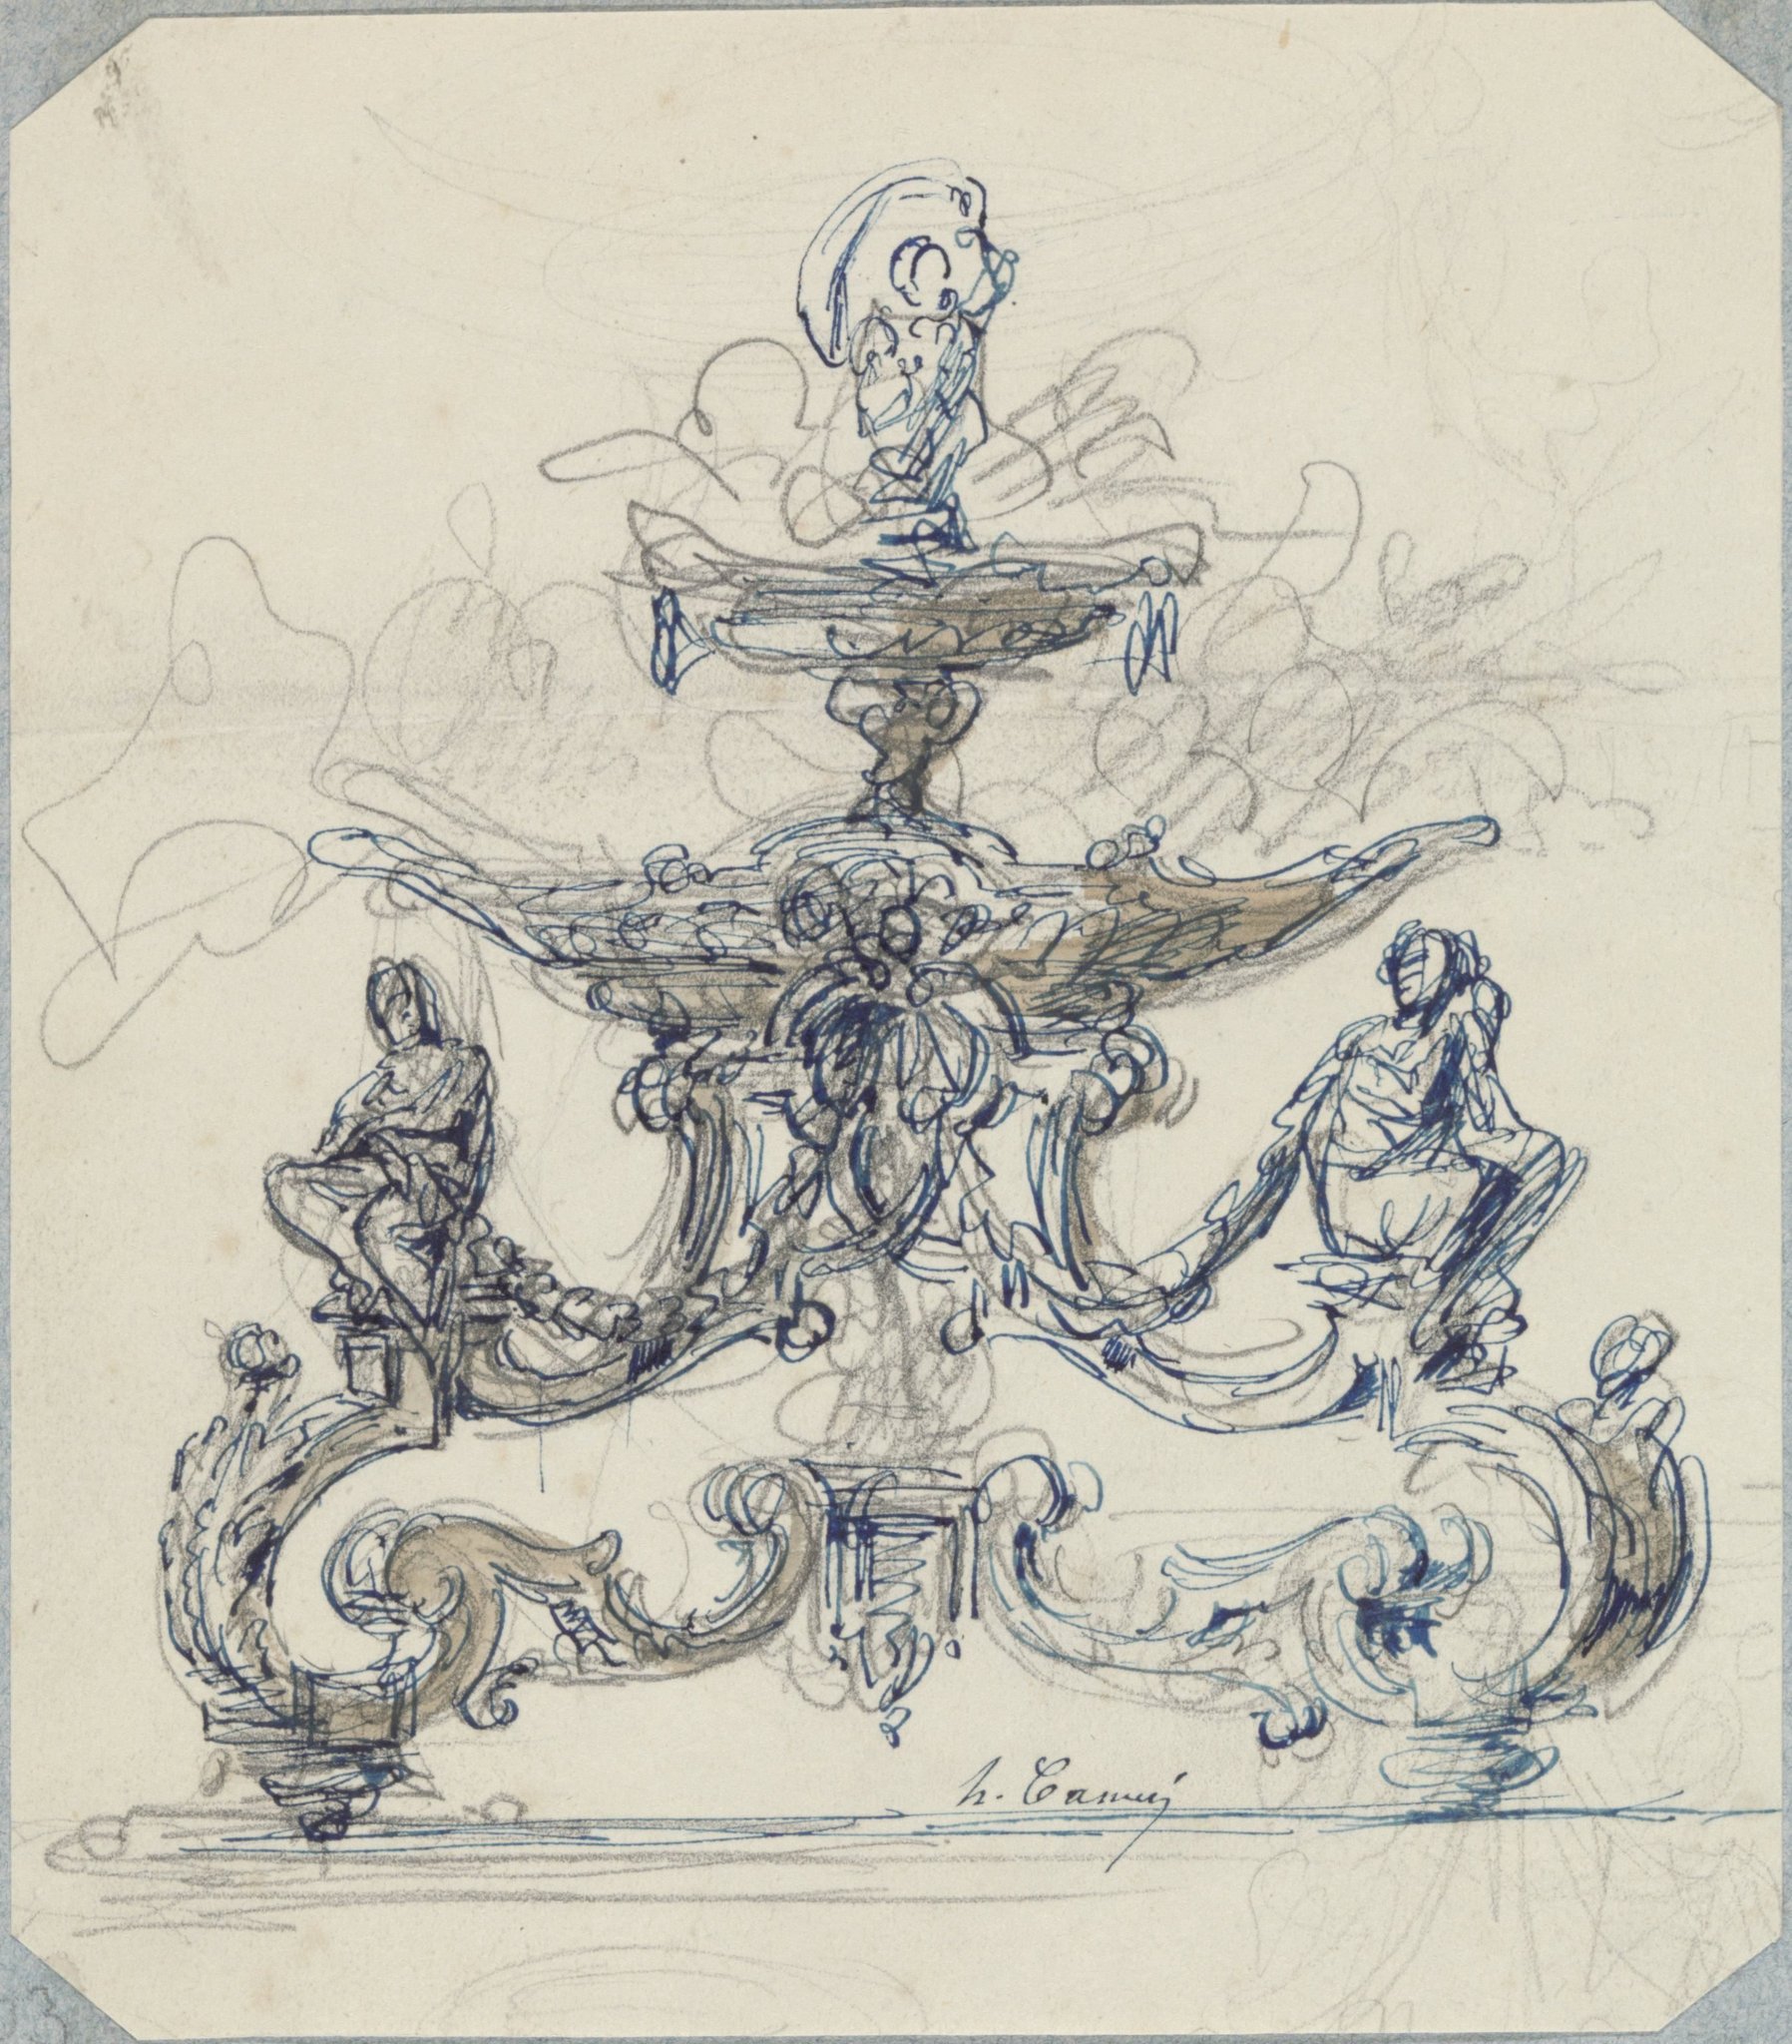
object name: design drawing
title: Ontwerp voor een tafelstuk of jardinière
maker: henri cameré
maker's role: designer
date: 1864-1894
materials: ink, paper, pencil, watercolor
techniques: brush, pen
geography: paris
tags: centre-piece, epergne, 'surtout', 'milieu-de-table'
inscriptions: signature: ‘h. Cameré’